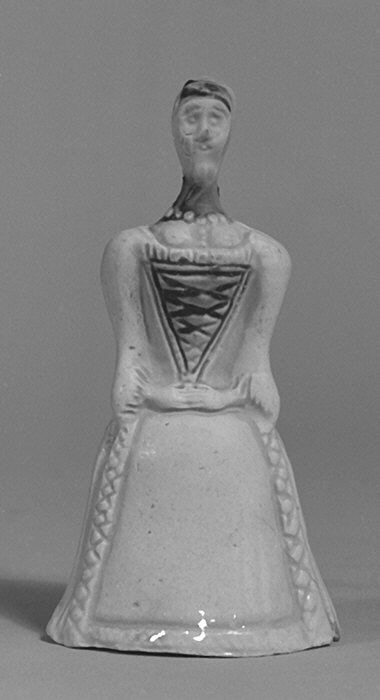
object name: figure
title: Figure of a lady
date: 1720-1740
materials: stoneware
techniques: salt glaze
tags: women